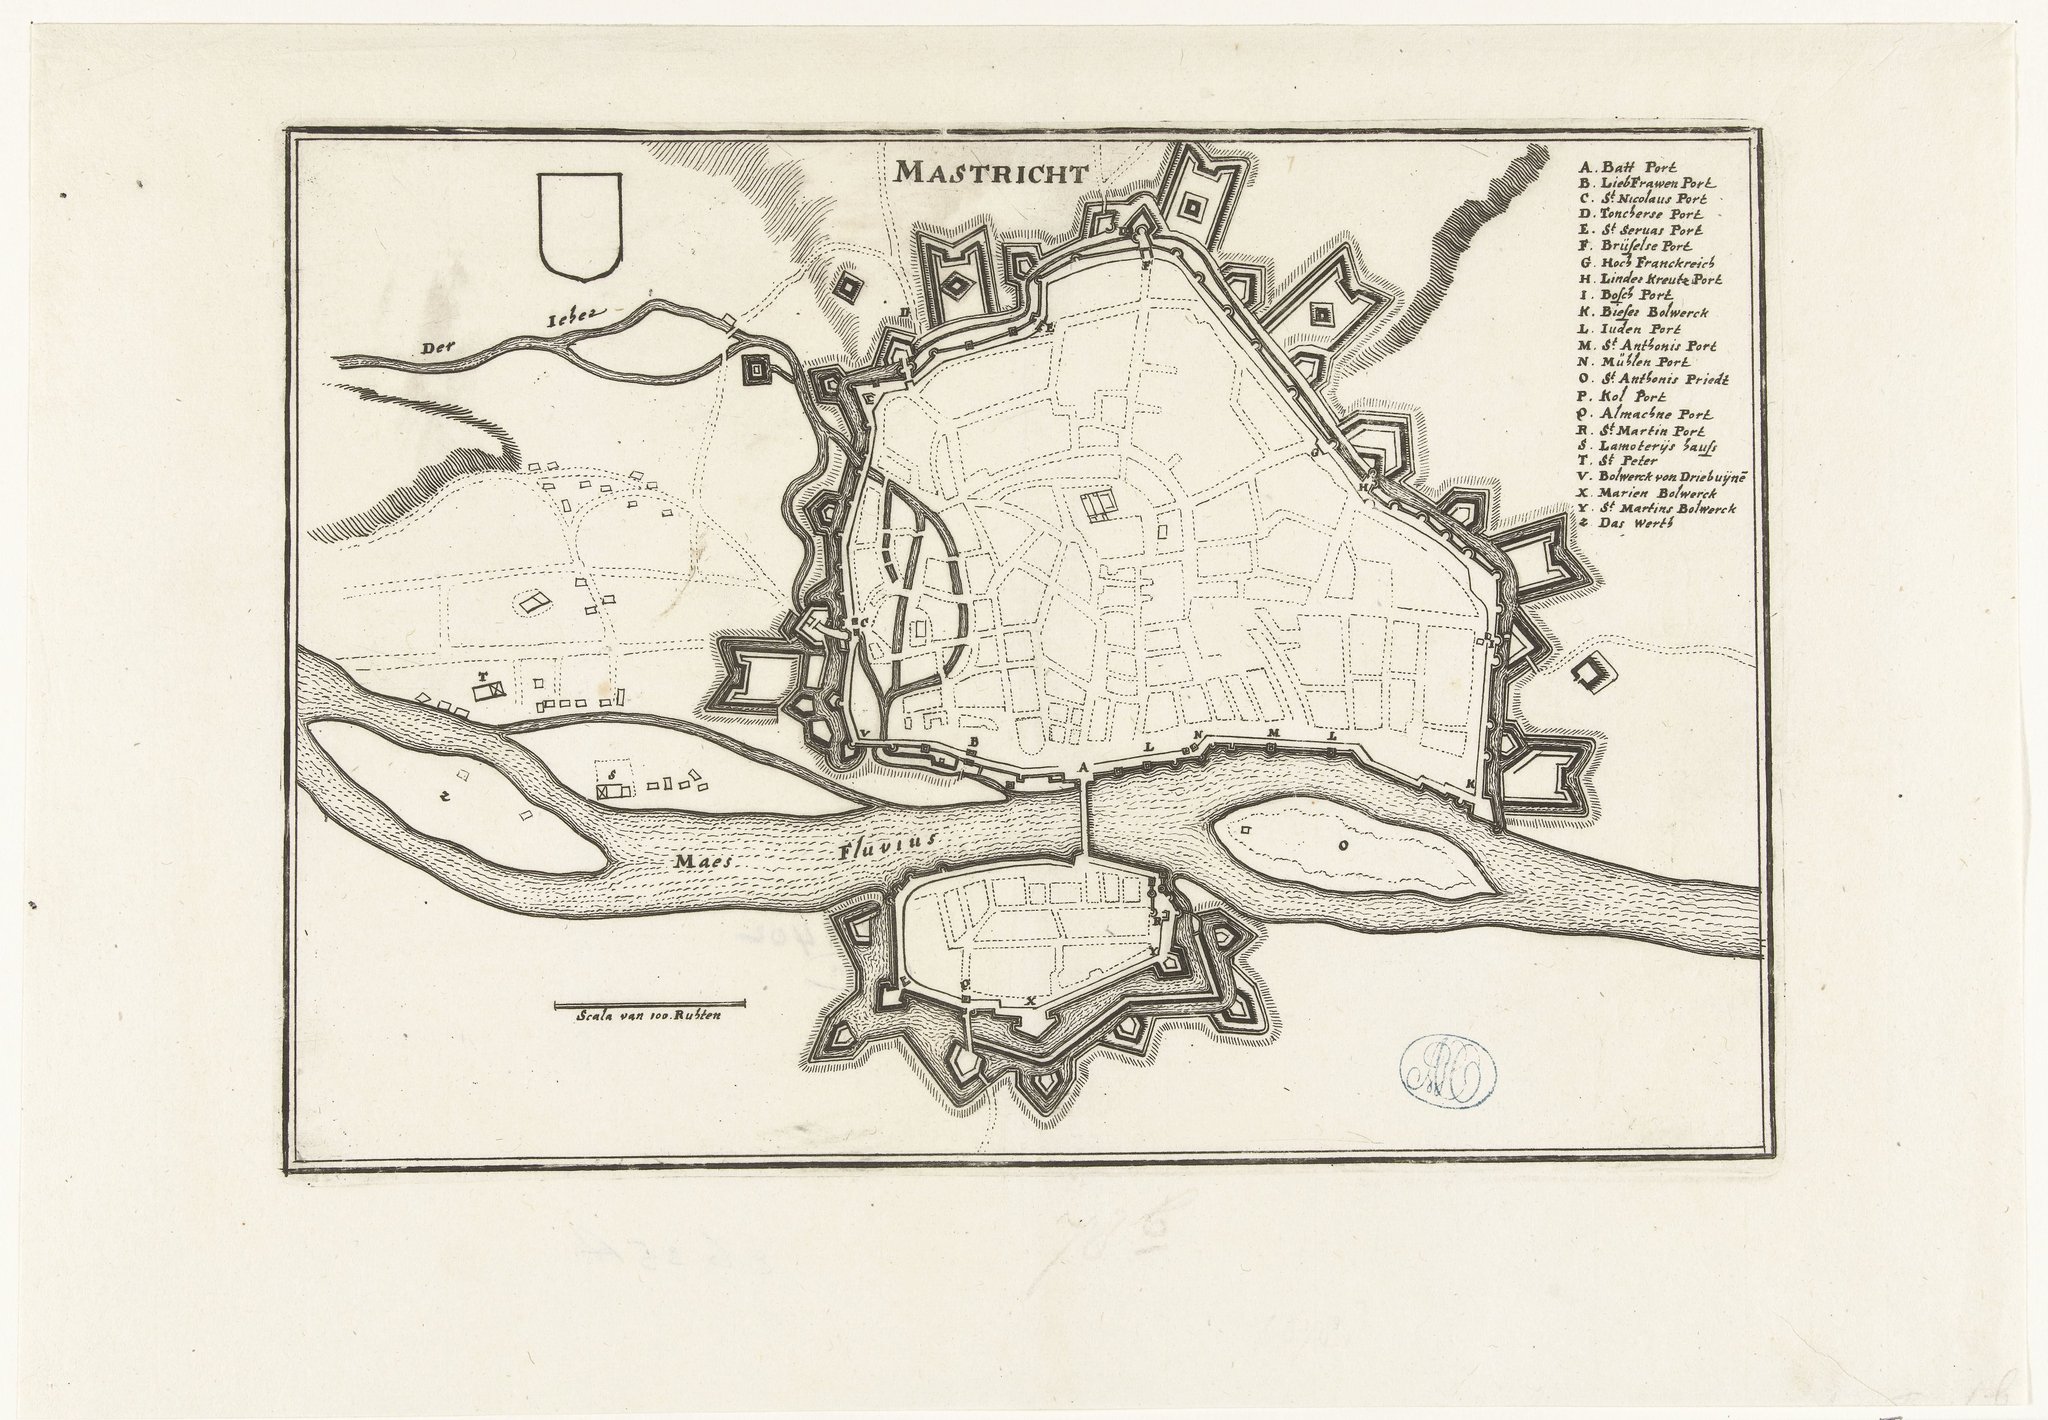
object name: print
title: Plattegrond van Maastricht, 1678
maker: Anonymous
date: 1678-1699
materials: paper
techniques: etching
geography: germany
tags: maps of cities, maastricht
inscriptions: collector's mark: Lugt 195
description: Plattegrond van Maastricht, met de vestingwerken zoals deze waren bij de teruggave van de stad door de Fransen bij de vrede van Nijmegen in 1678. Met legenda A-Z in het Duits.